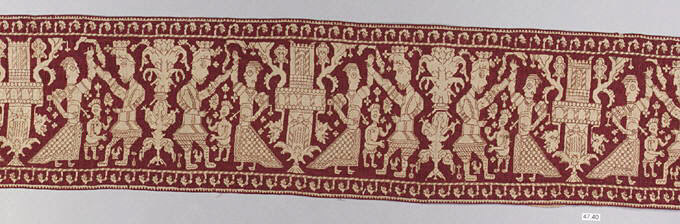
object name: border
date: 1601-1700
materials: linen, silk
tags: children,men,women